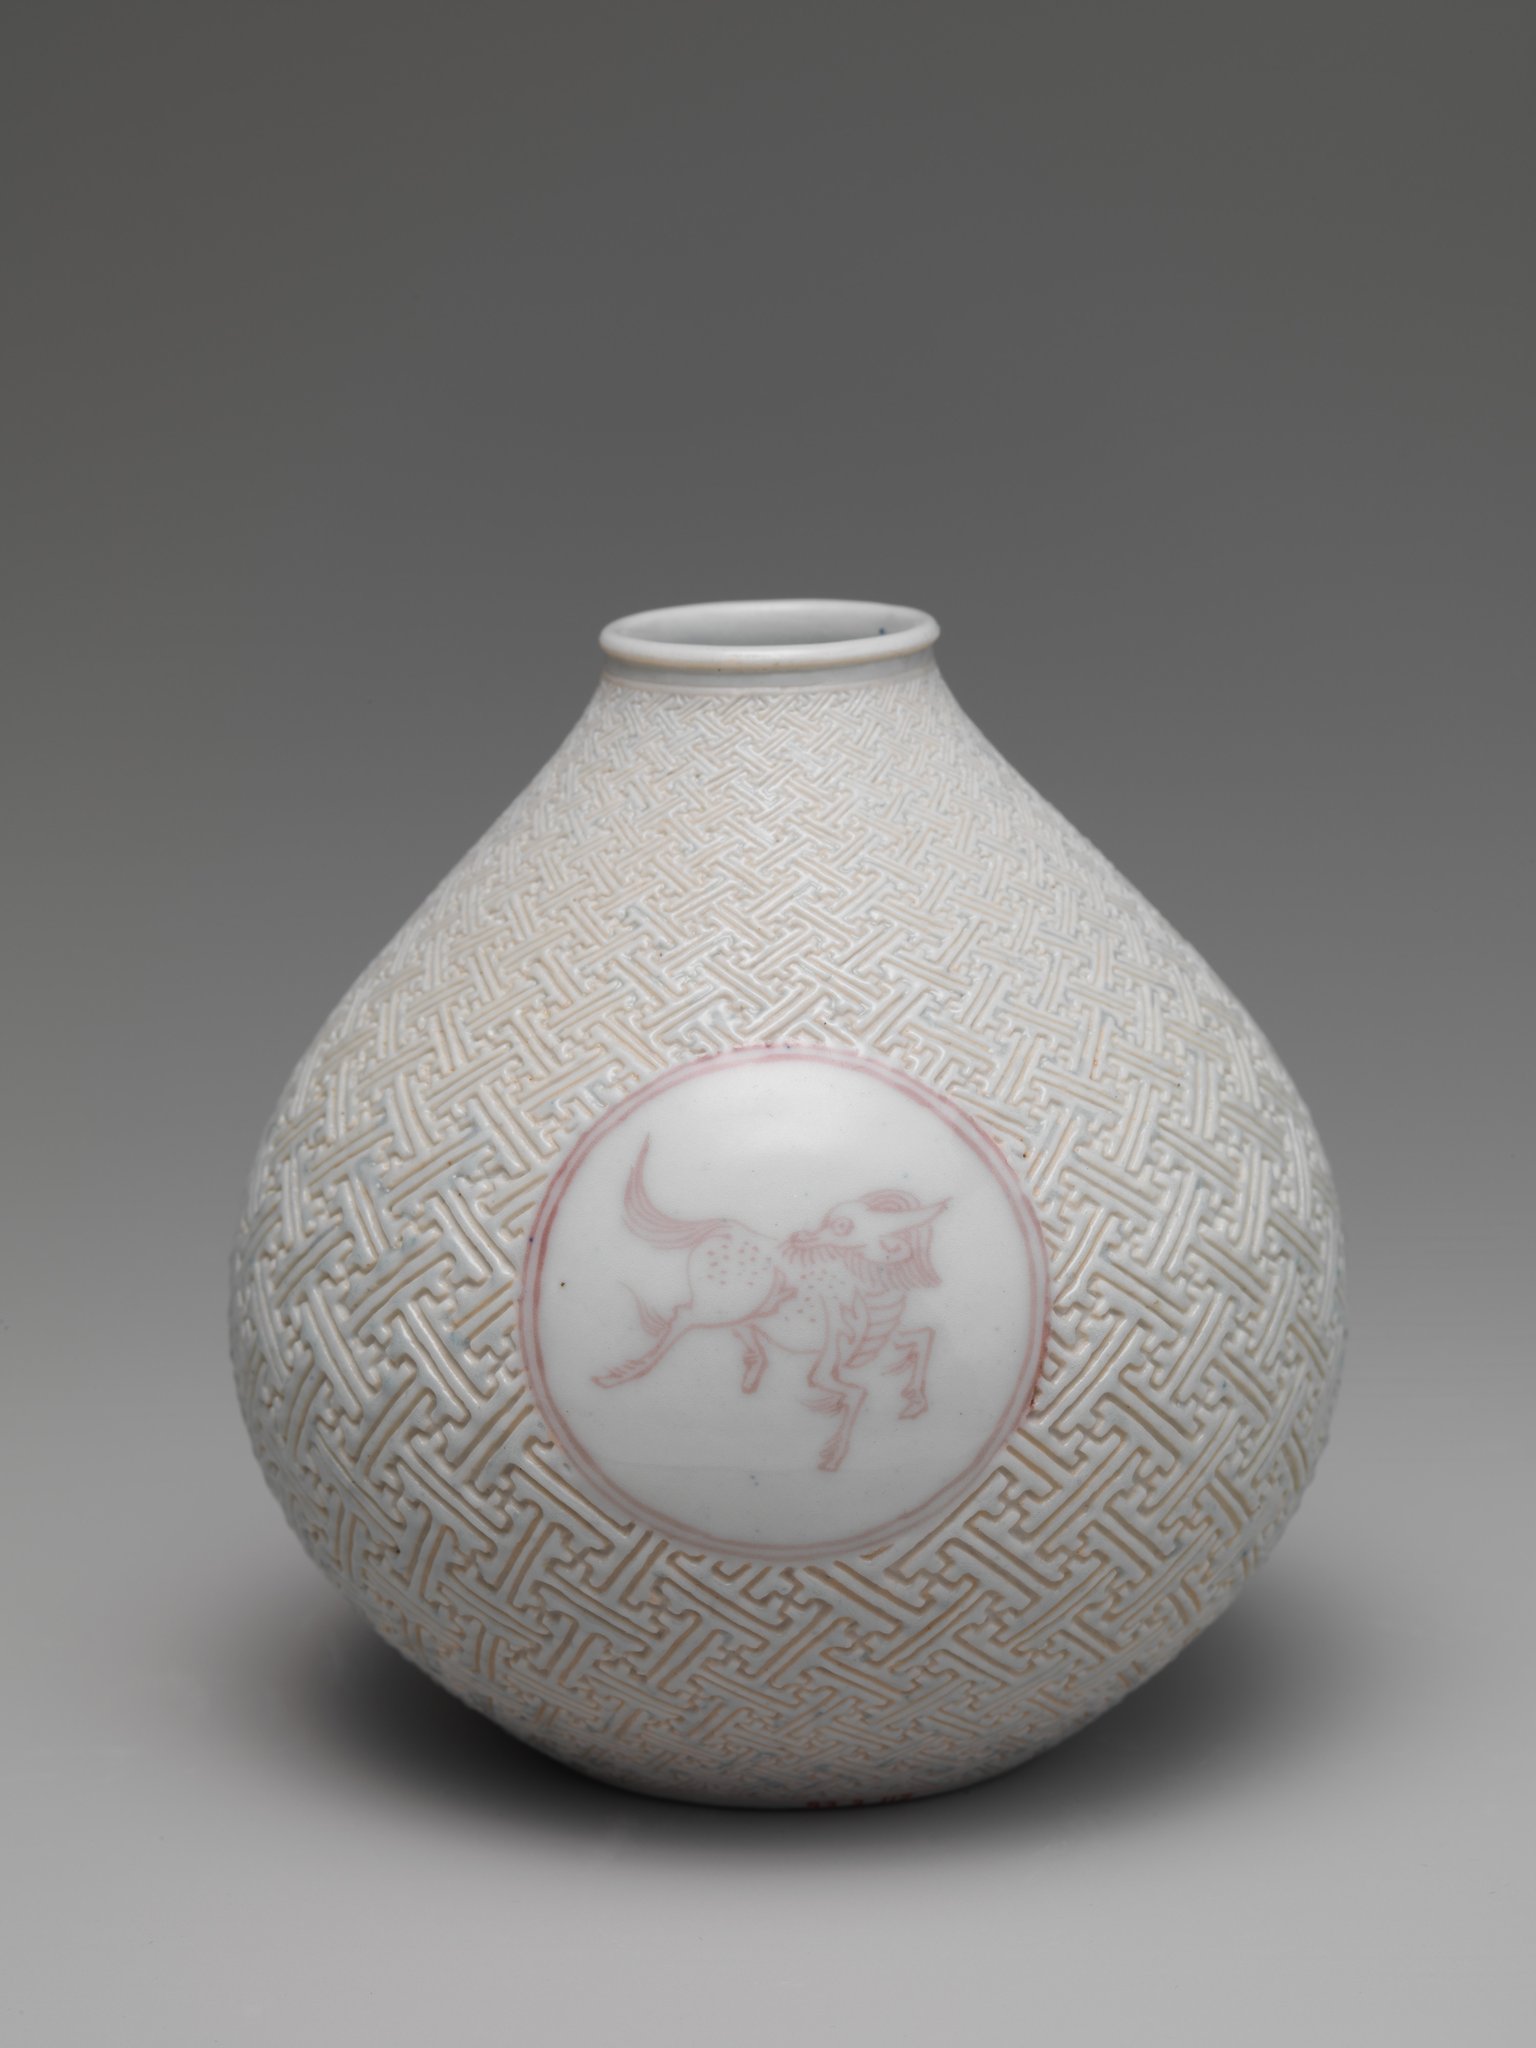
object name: flower vase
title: Vase with Horse and Kirin on Geometric Sayagata (key fret) Pattern (one of a pair)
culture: japanese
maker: makuzu kōzan i (miyagawa toranosuke)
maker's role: artist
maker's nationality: japanese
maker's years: 1842-1916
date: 1867-1900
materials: porcelain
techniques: incising, underglaze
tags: animals